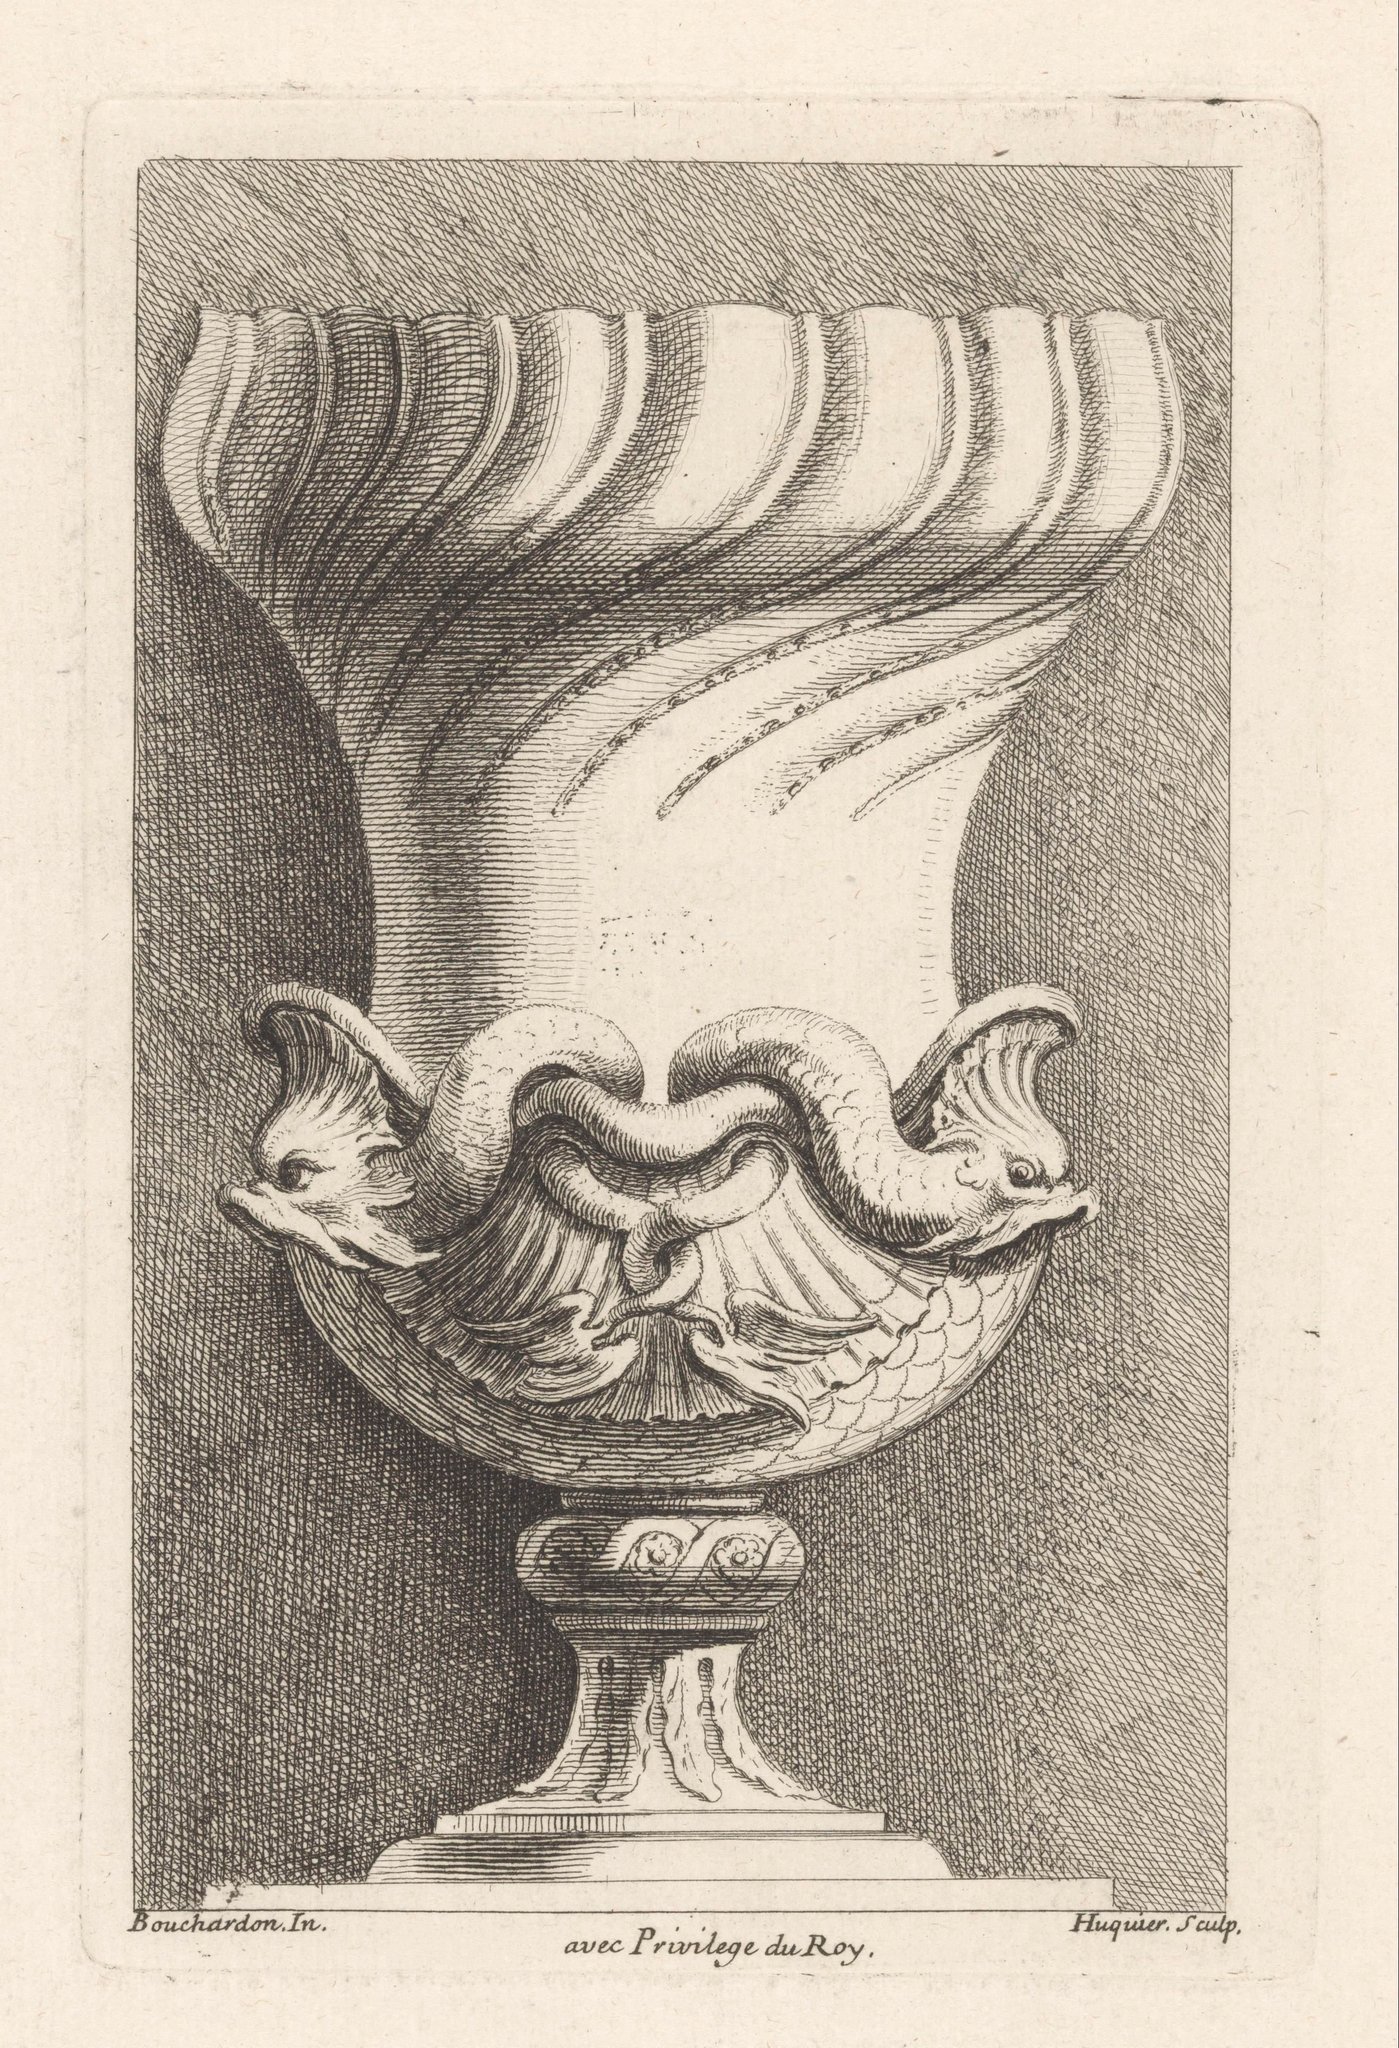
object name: print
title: Premier livre de vases (...)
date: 1729-1737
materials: paper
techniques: etching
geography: paris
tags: dolphin ~ ornament, vase ~ ornament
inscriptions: collector's mark: Lugt 2228